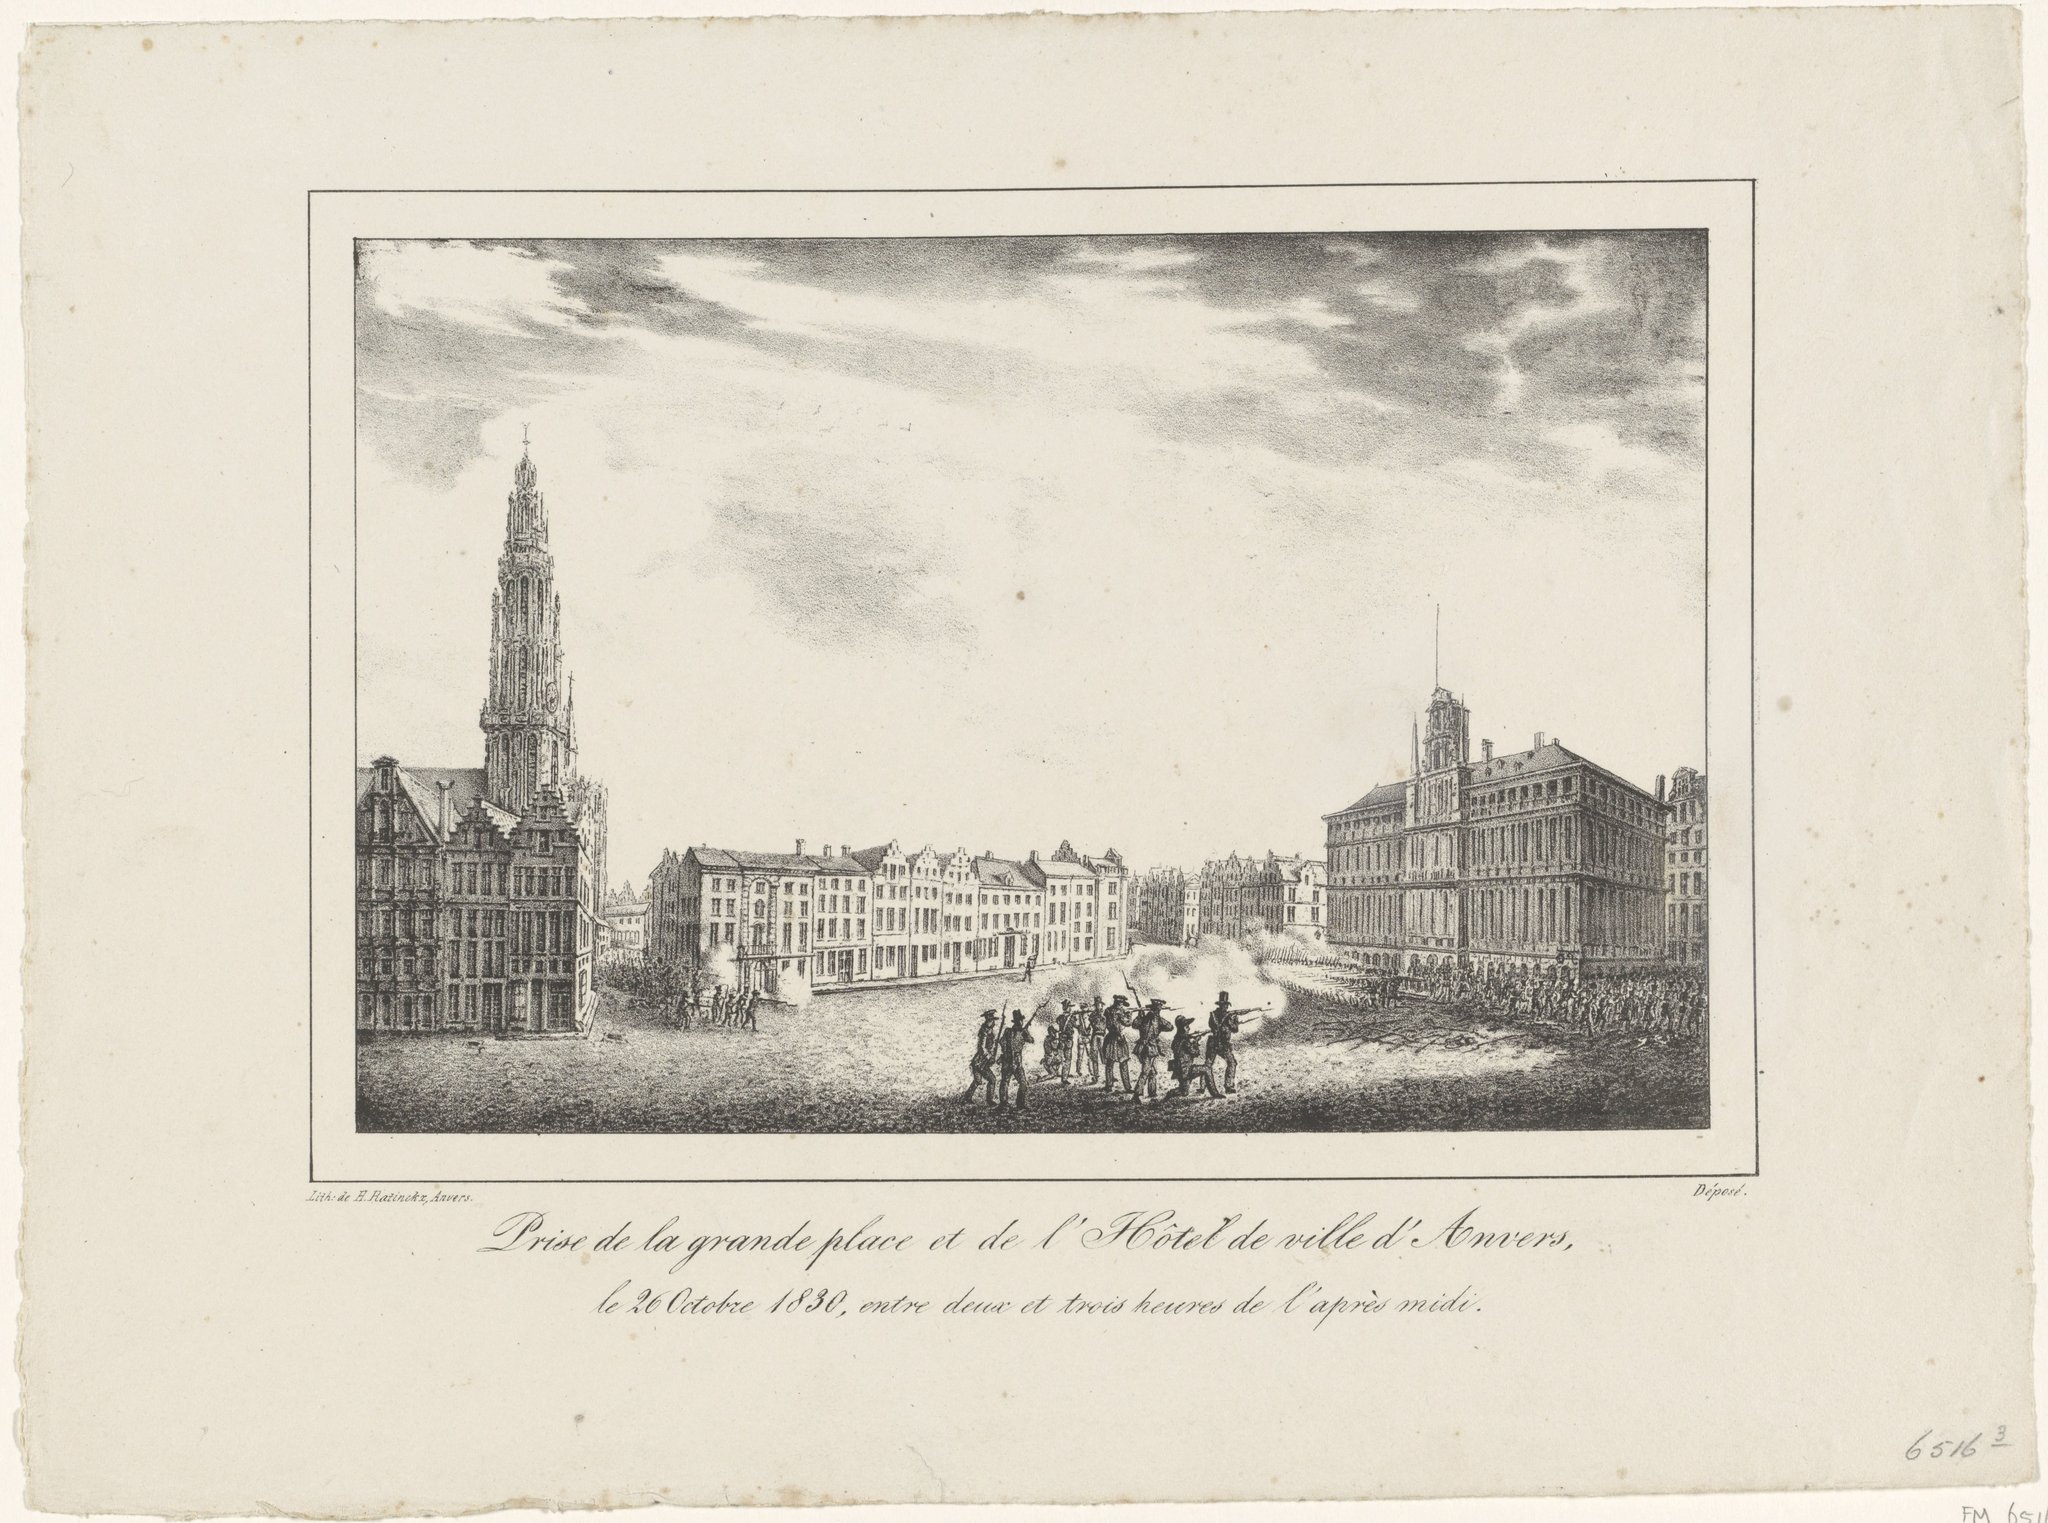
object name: print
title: Prise de la grande place et de l'Hôtel de ville d'Anvers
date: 1830-1831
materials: paper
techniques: lithograph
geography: antwerp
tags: street-fights, riots, antwerp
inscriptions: collector's mark: Lugt 2228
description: Onder FMH 6516 beschrijft Muller een serie van acht platen over de gebeurtenissen te Antwerpen van 26-27 oktober 1830, gedrukt bij Ratinckx te Antwerpen. In het Supplement worden onder het nummer 6516A nog eens negen platen vermeld die waarschijnlijk tot dezelfde serie behoren. Daarnaast bezit het RPK nog twee platen die waarschijnlijk tot dezelfde reeks behoren. Hier worden deze negentien platen beschreven als deel uit makend van één en dezelfde serie.